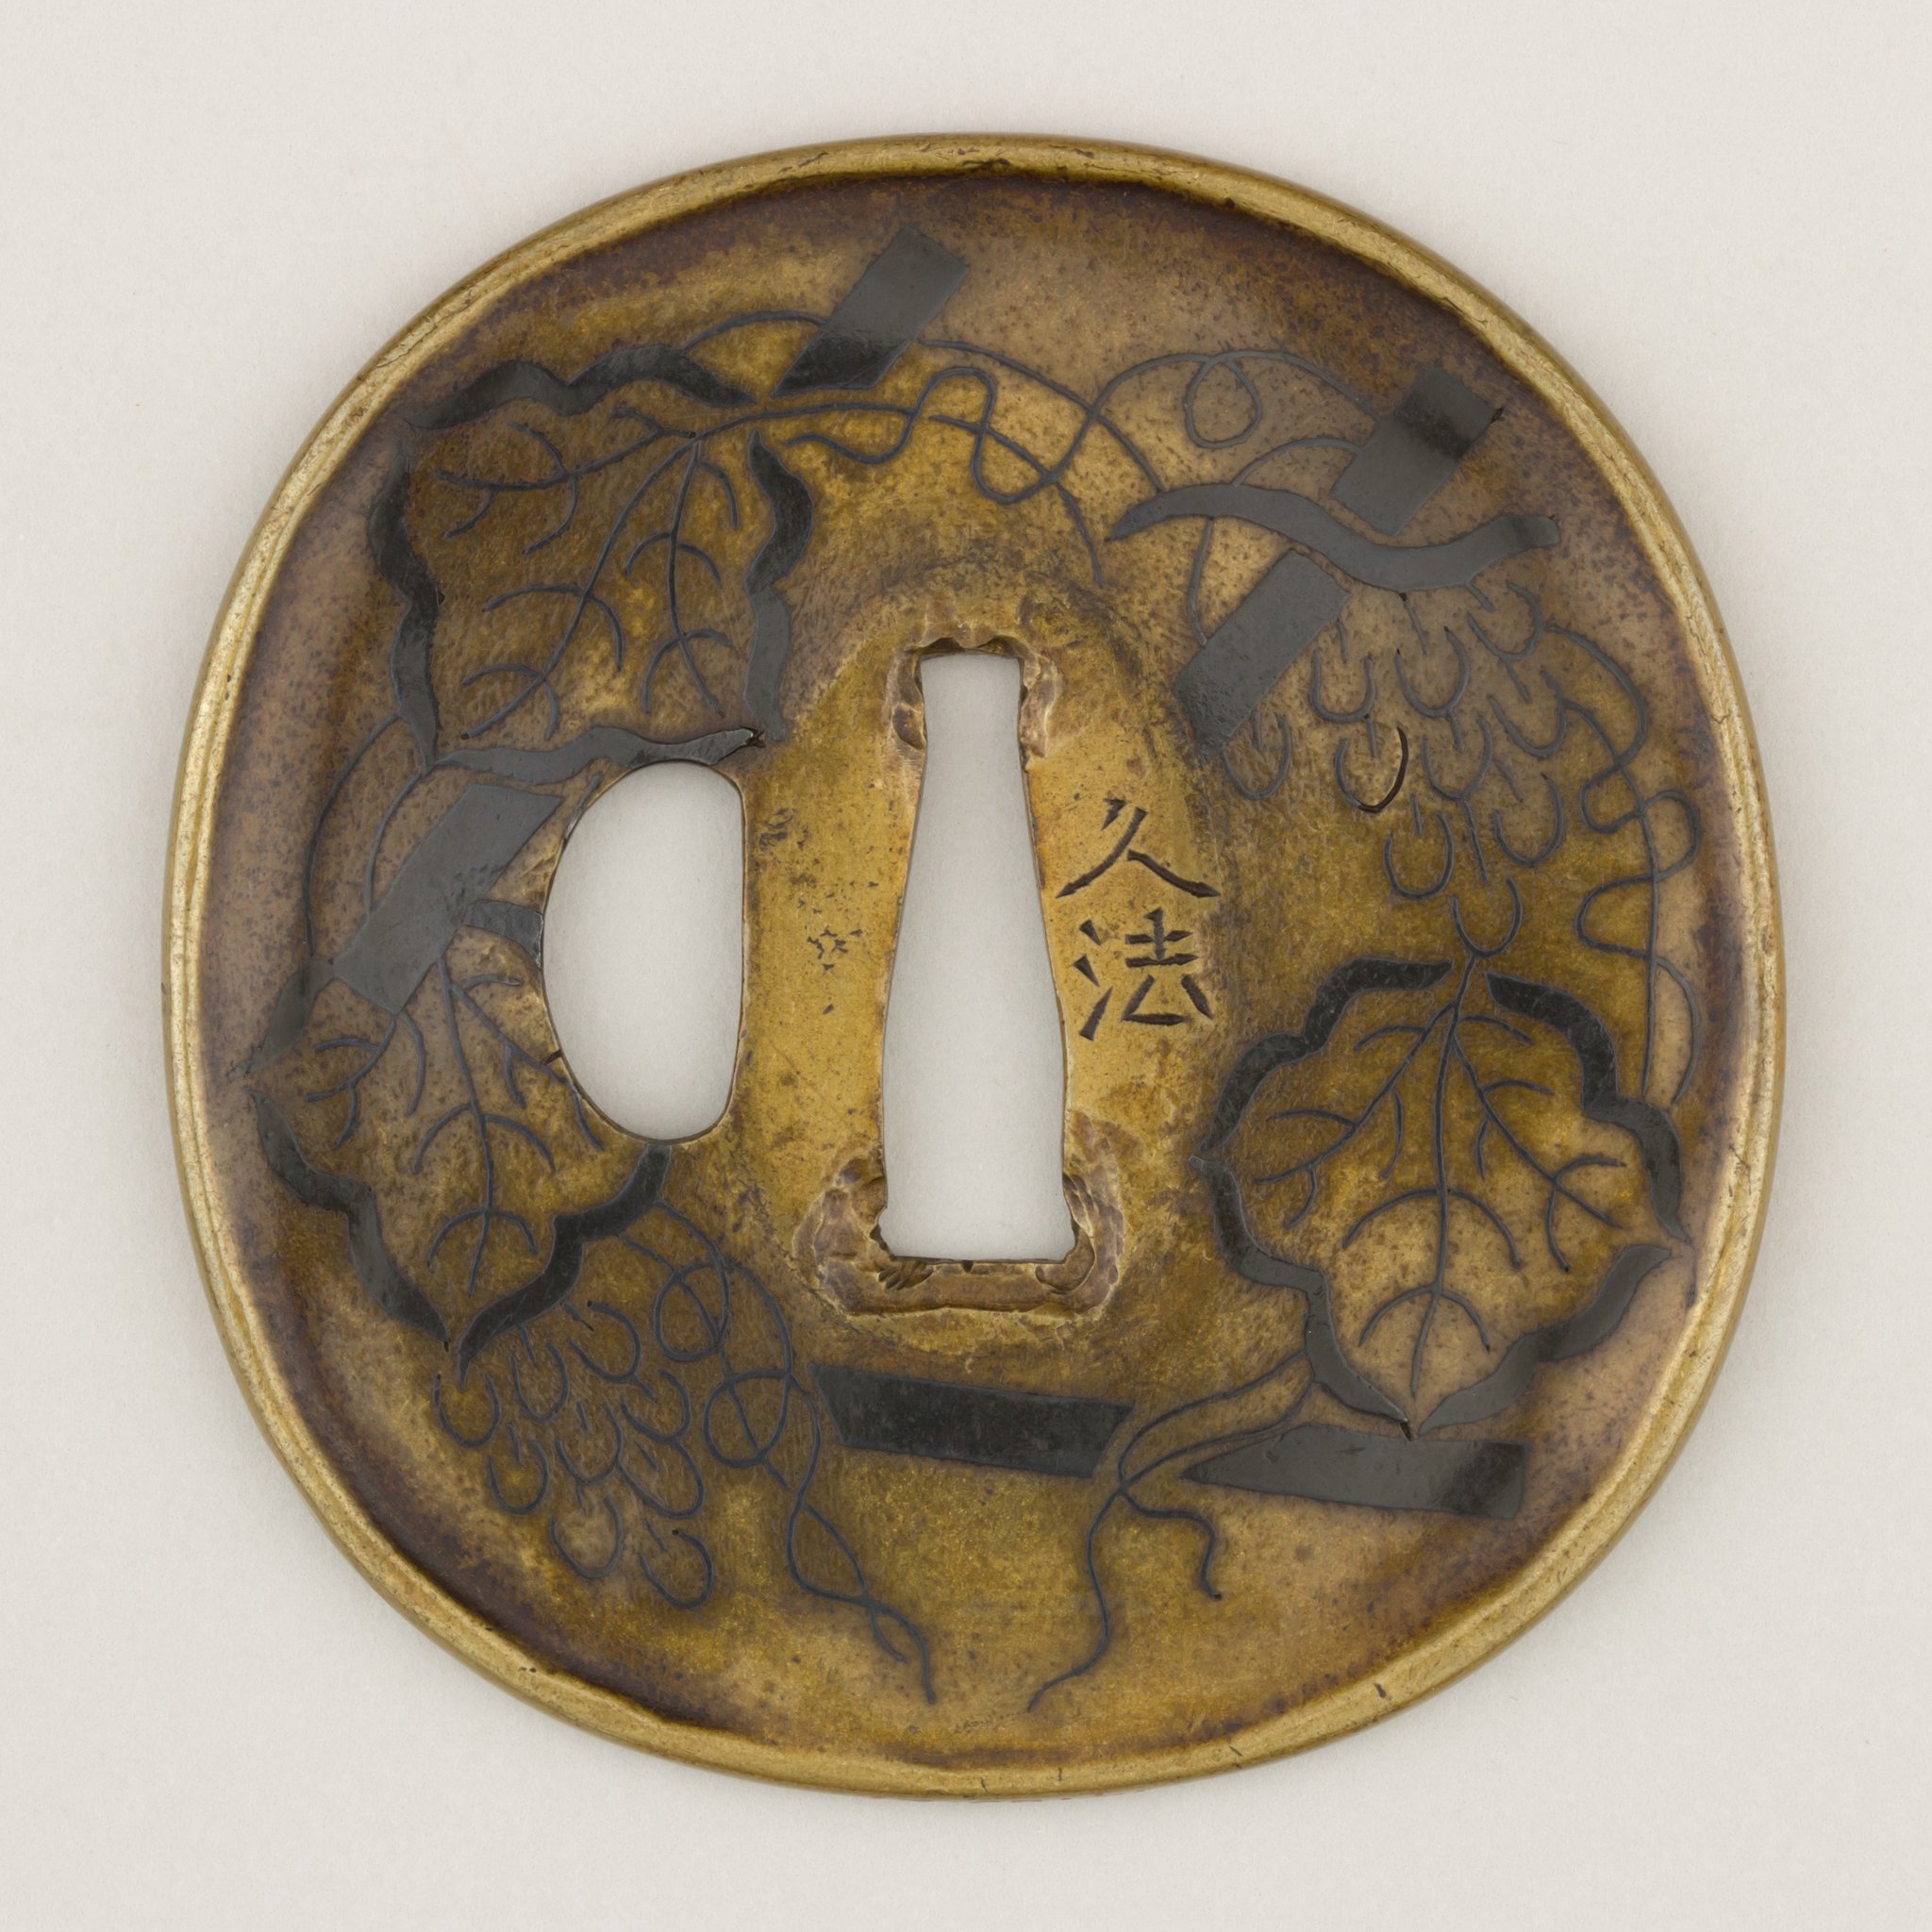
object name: sword guard tsuba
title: Sword guard (Tsuba) With Grapevines on Trellis Motif (葡萄棚図鐔)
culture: japanese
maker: hisanori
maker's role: fittings maker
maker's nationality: japanese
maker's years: 1575-1725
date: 1601-1700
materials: brass, gold alloy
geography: japan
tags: grapes